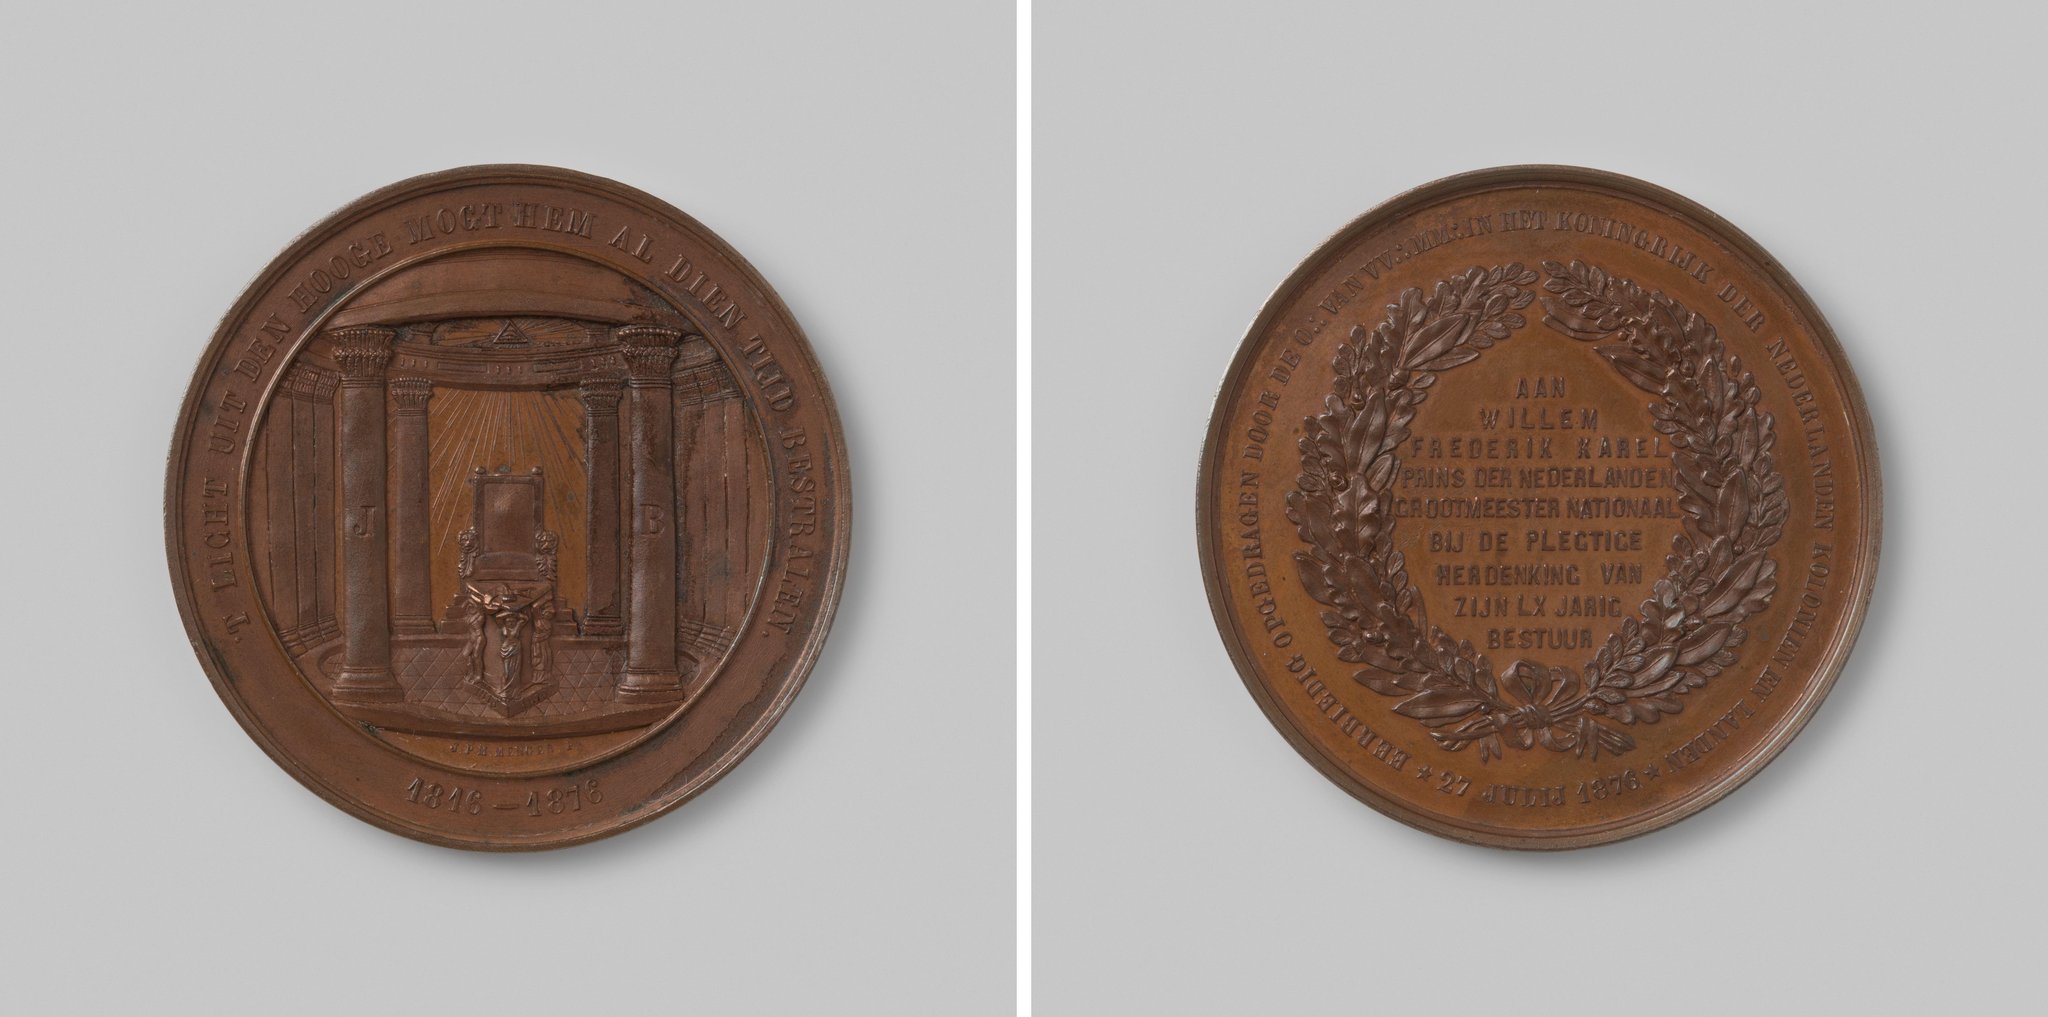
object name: honorary medal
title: Frederik, prins der Nederlanden, zestig jaar grootmeester der vrijmetselarij, penning geslagen op last van de loges van het Koninkrijk der Nederlanden en de kolonien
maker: johan philip mathias menger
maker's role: medailleur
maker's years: 1845-1905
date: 1866-1876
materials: bronze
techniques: striking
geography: utrecht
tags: berlin, frederik (prins der nederlanden)